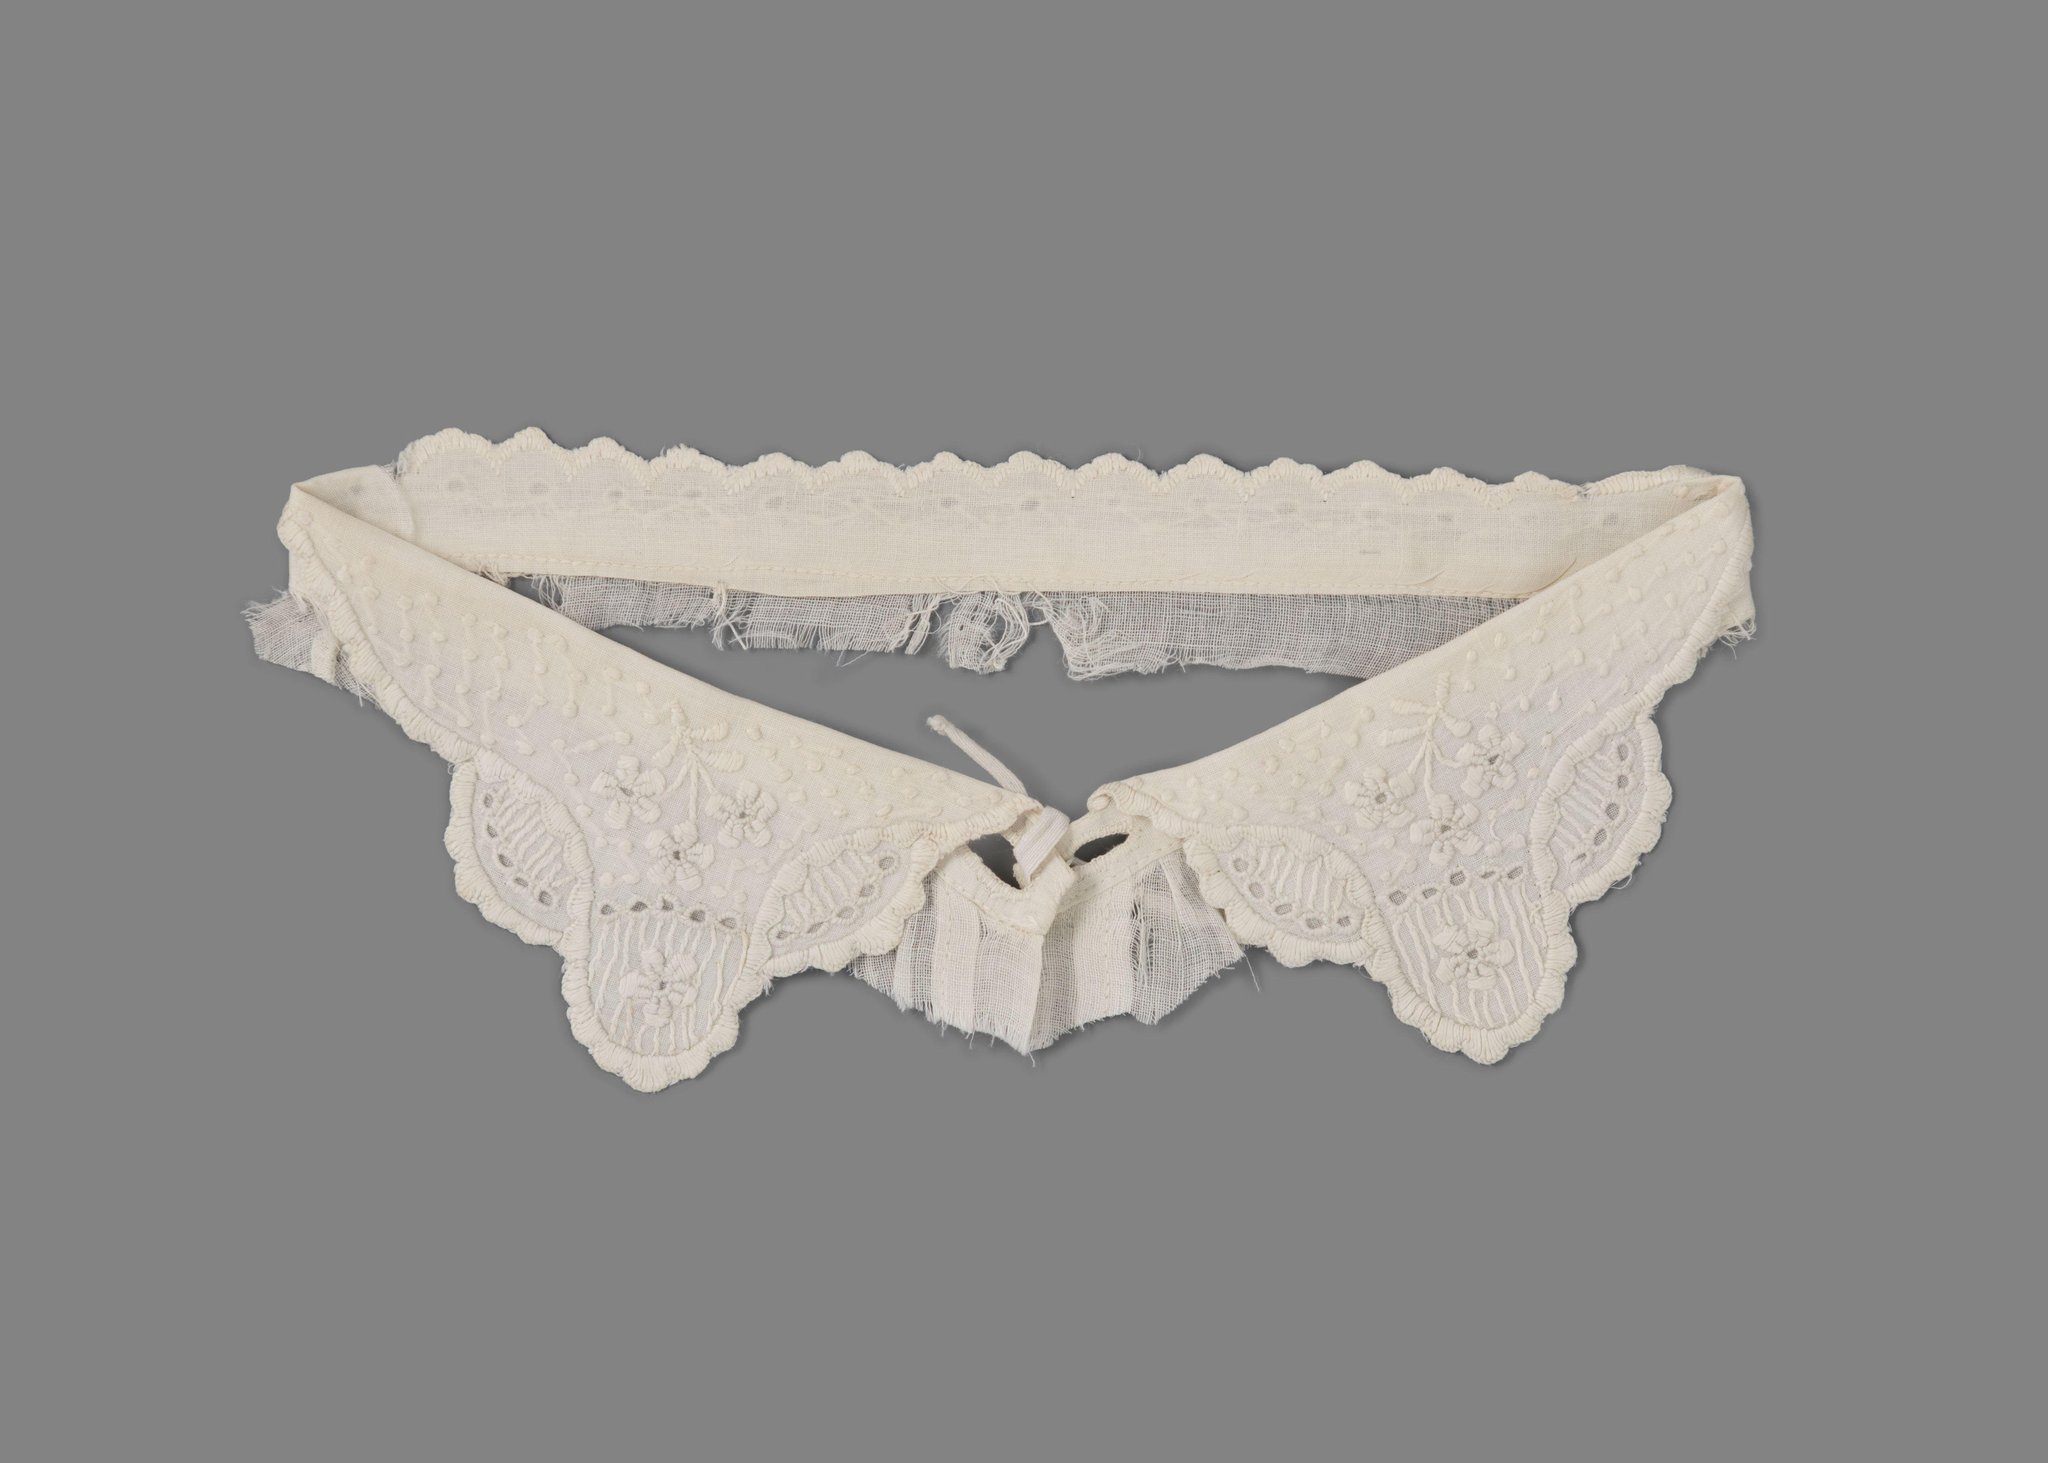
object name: collar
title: Kraag van katoen met staande boord met twee geschulpte omslagpunten met witwerk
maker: Anonymous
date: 1875-1900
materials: cotton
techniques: embroidery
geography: western europe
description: Kraag van katoen met staande boord met twee gefestonneerde geschulpte en ondergeschulpte omslagpunten. Het witwerk op de omslagen bestaat uit moesjes en violen. De achterzijde van de boord is eveneens geschulpt en voorzien van moesjes tussen opengewerkte cirkels.